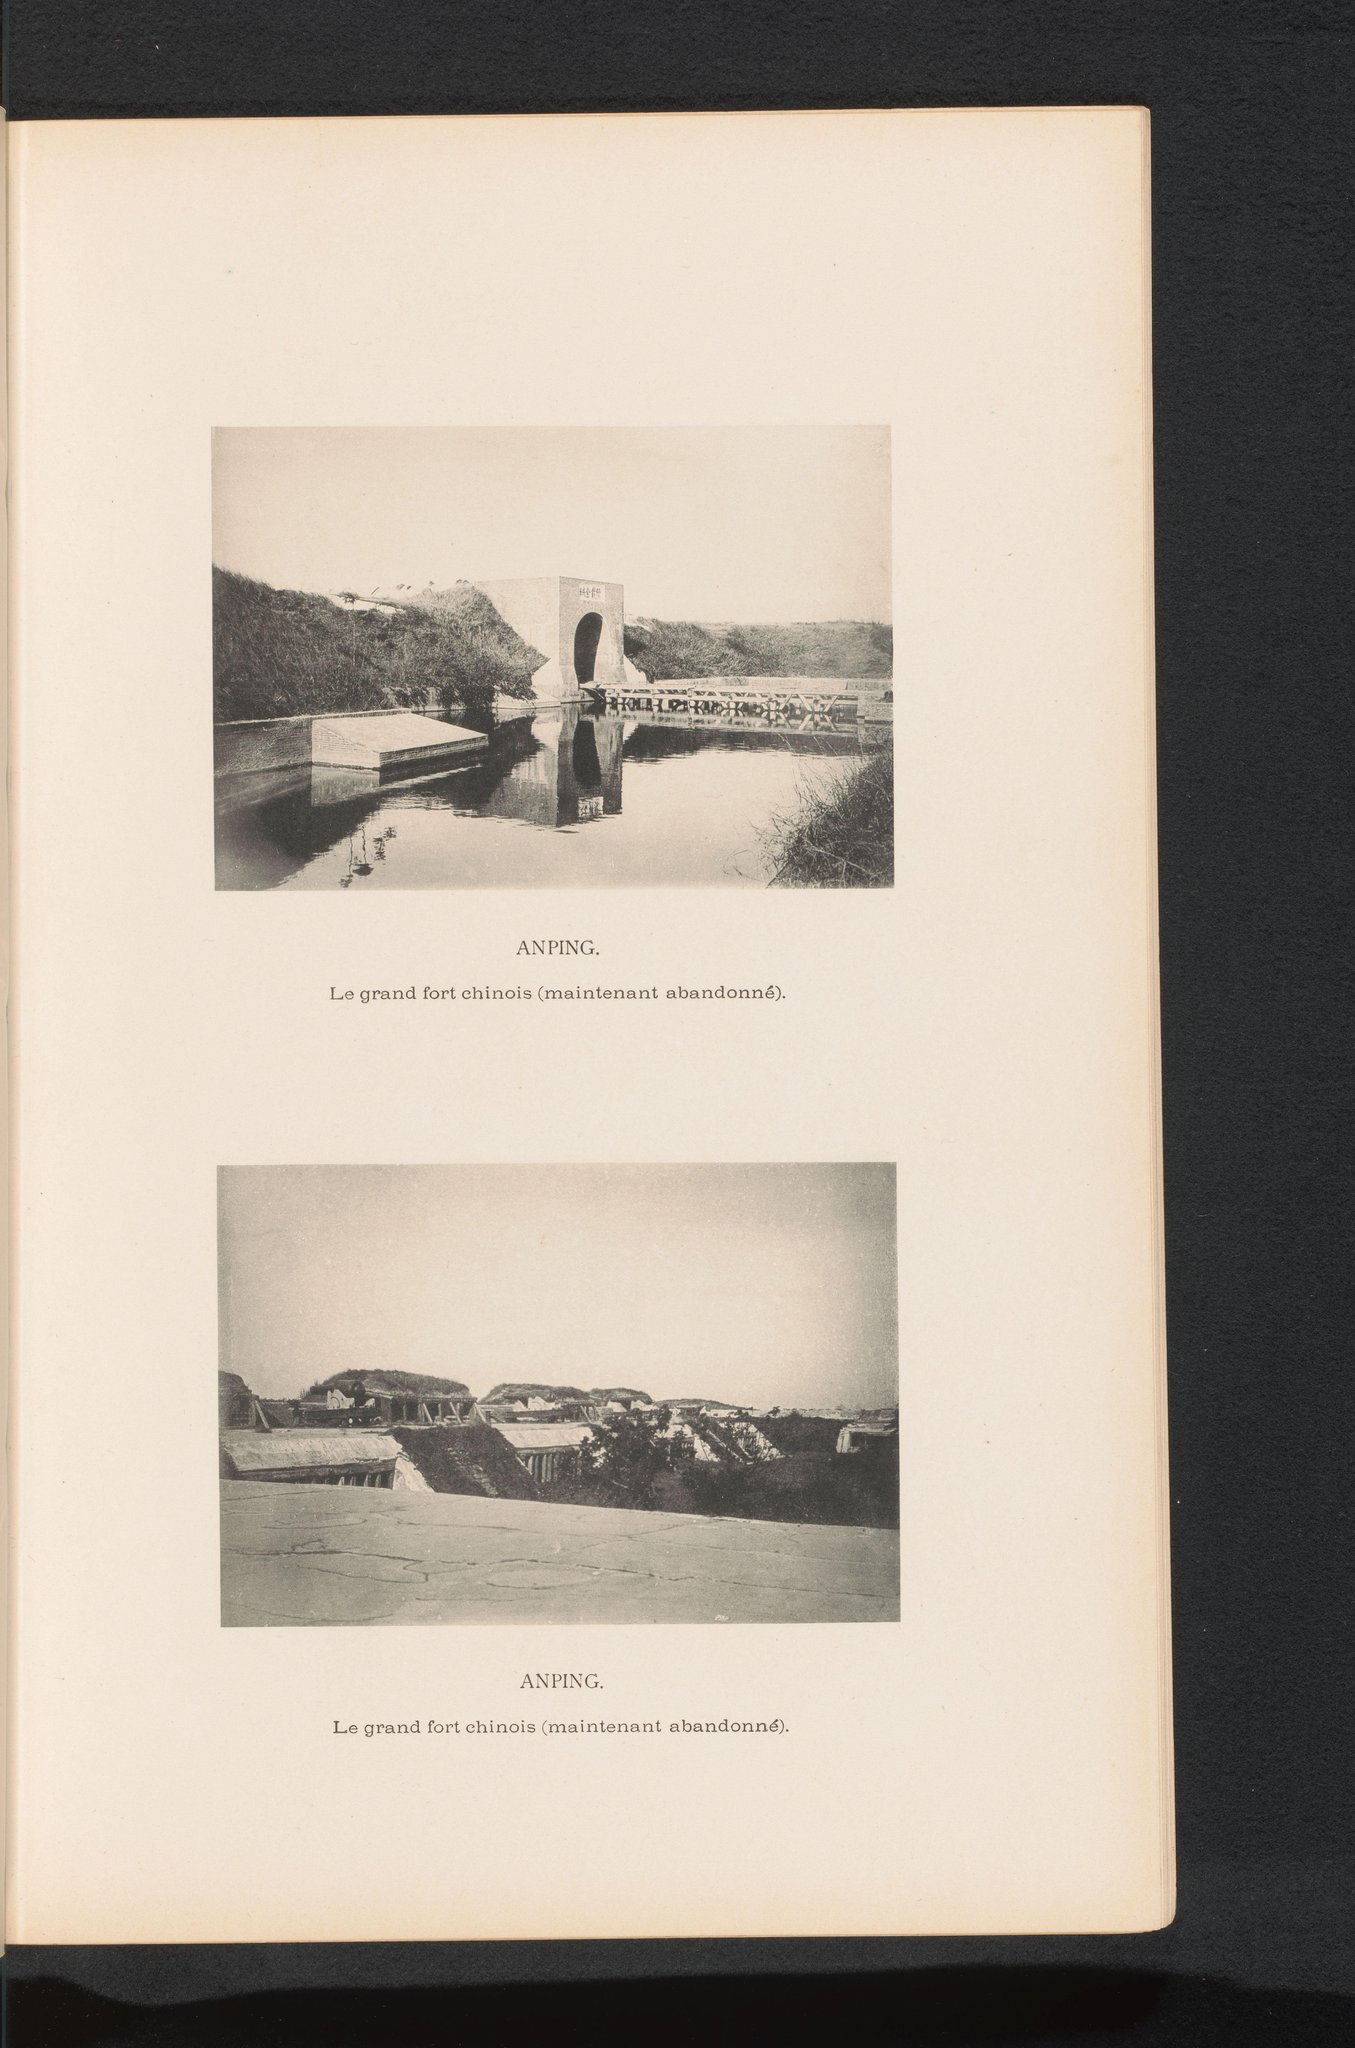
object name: photomechanical print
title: Twee gezichten op een verlaten fort te Anping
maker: Anonymous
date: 1891-1896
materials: paper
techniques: photograph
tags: fortress